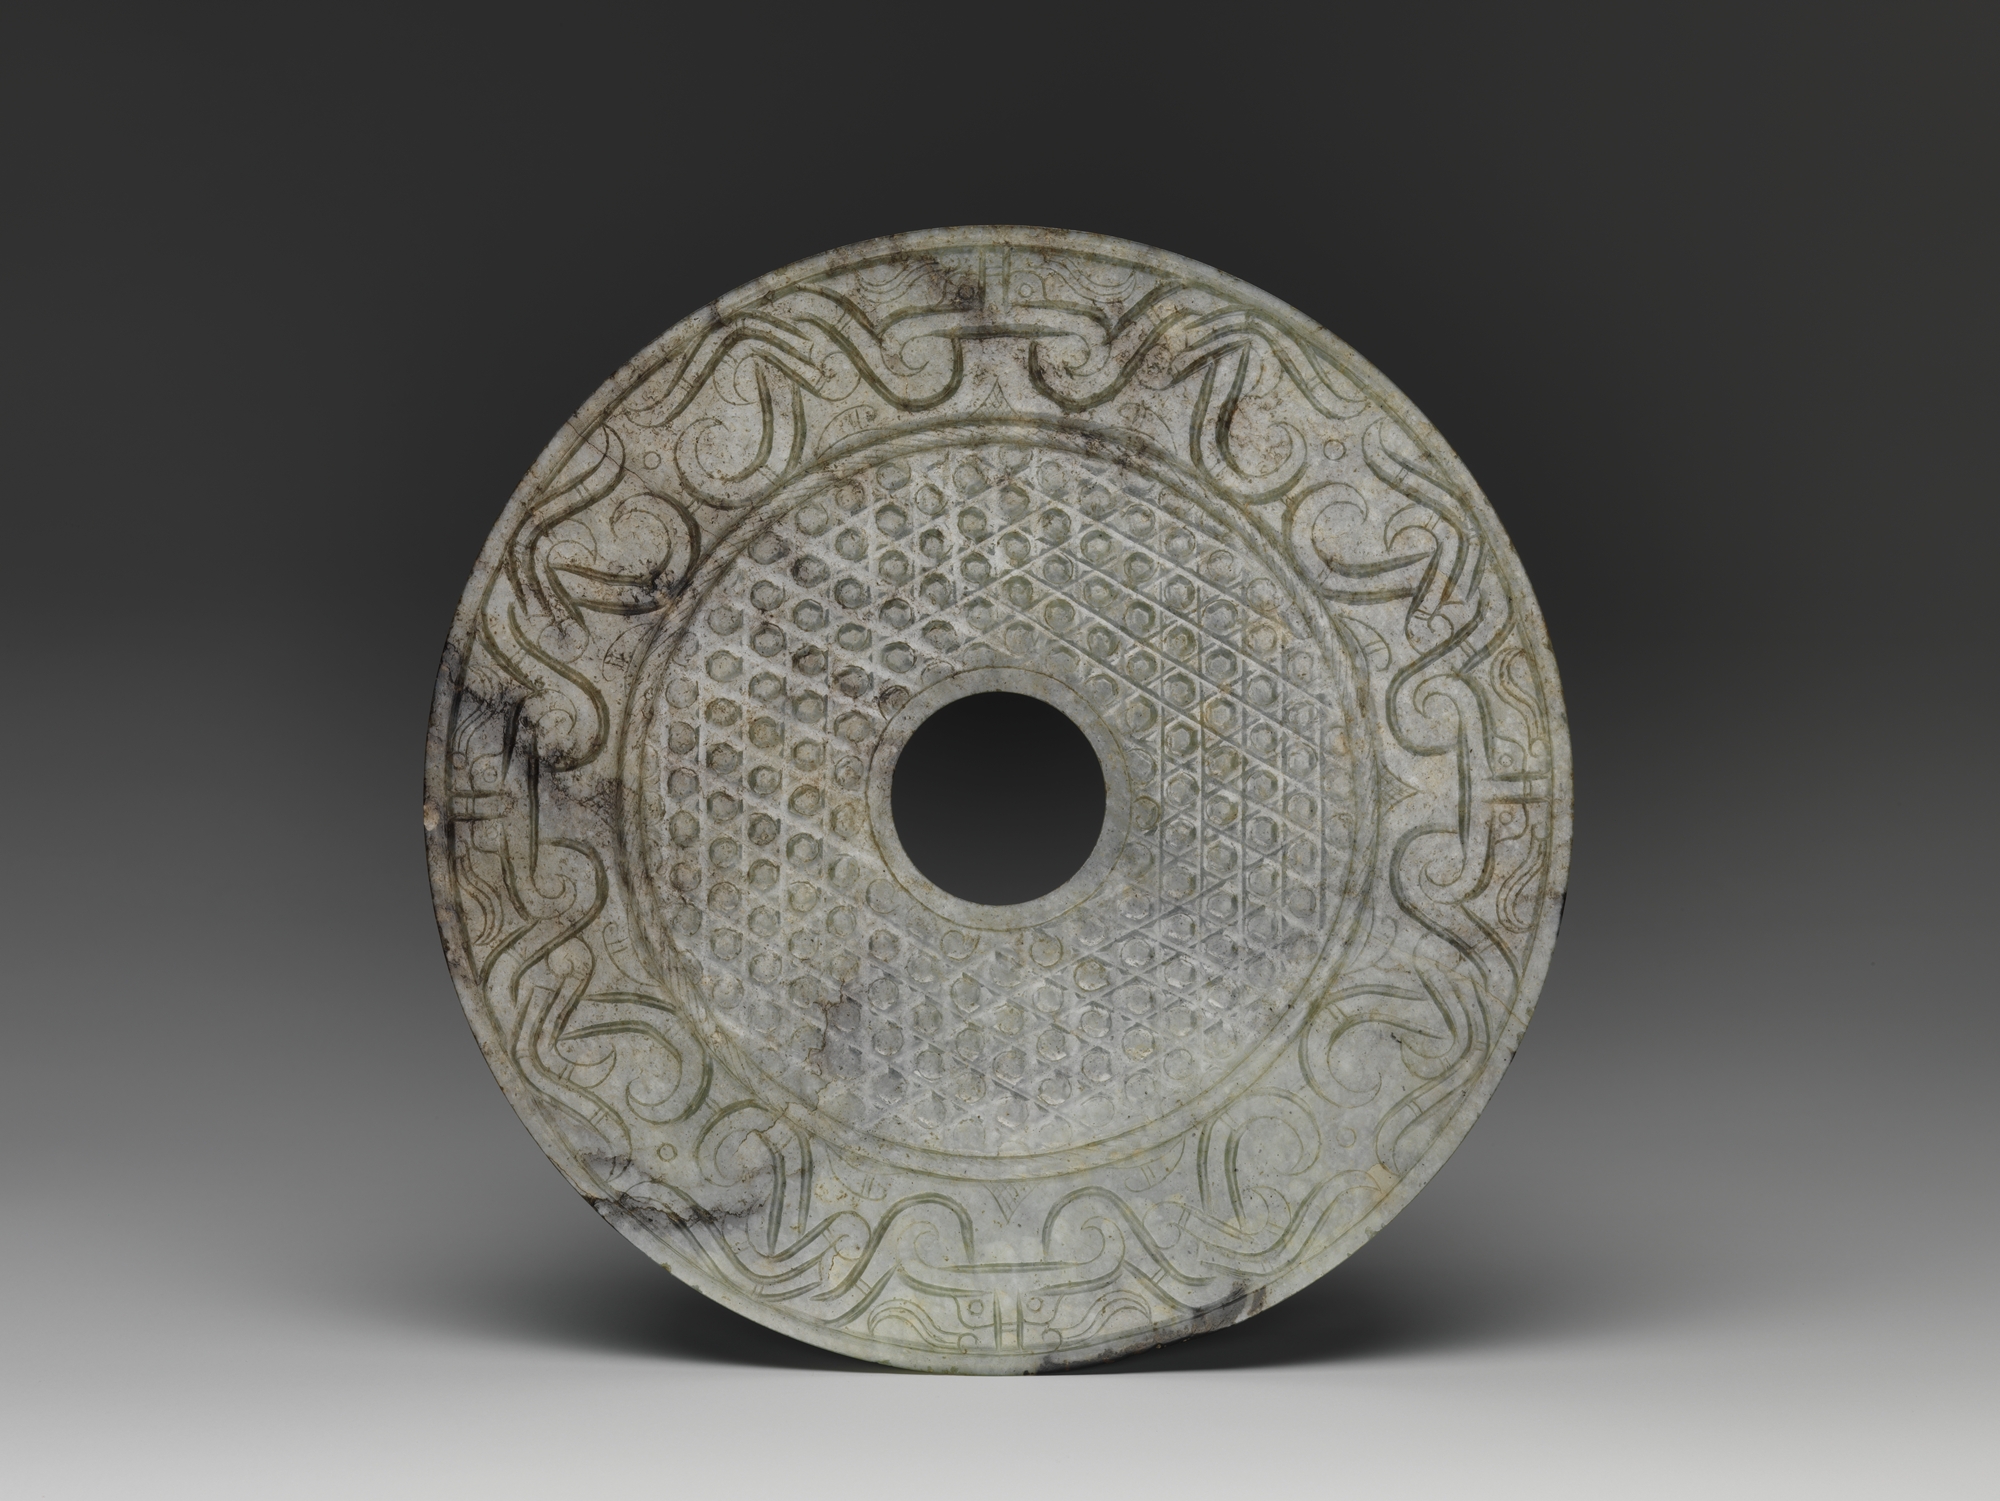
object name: disc bi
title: Disc (Bi)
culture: chinese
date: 200-101 BCE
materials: jade